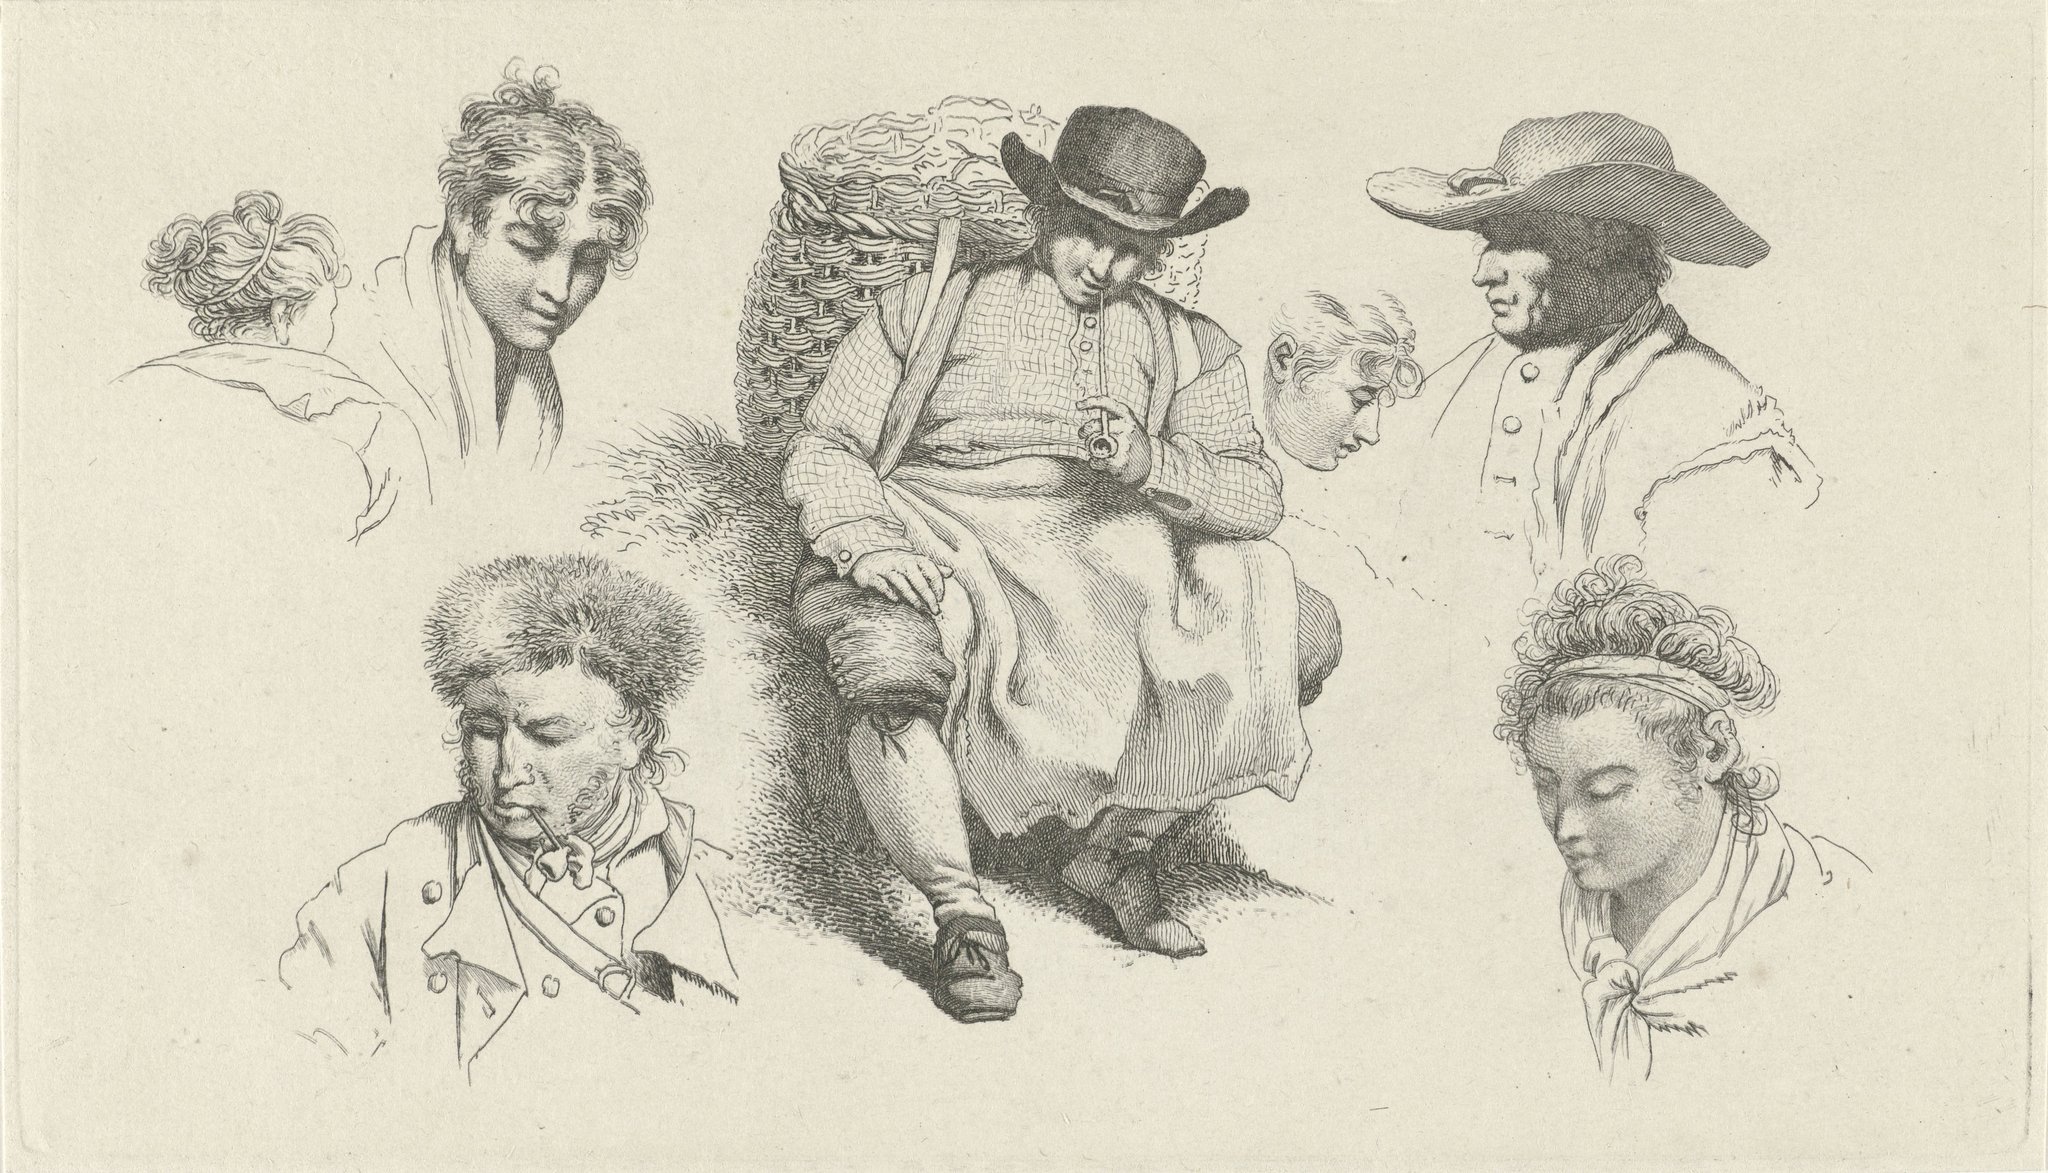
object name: print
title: Studieblad met figuren en een rustende visboer met pijp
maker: jacob ernst marcus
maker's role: draughtsman, print maker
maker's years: 1774-1826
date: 1803-1808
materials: paper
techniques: etching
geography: amsterdam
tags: adult man (+ sitting), head (human), pipe ~ tobacco, container made of plant material other than wood: basket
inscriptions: collector's mark: Lugt 2228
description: Serie voor het eerst uitgegeven door Jacob Ernst Marcus onder de titel Studiebeelden en Fragmenten. Amsterdam: ca.1816. Later heruitgegeven als: Studie-prentwerk/ Etudes gravées.